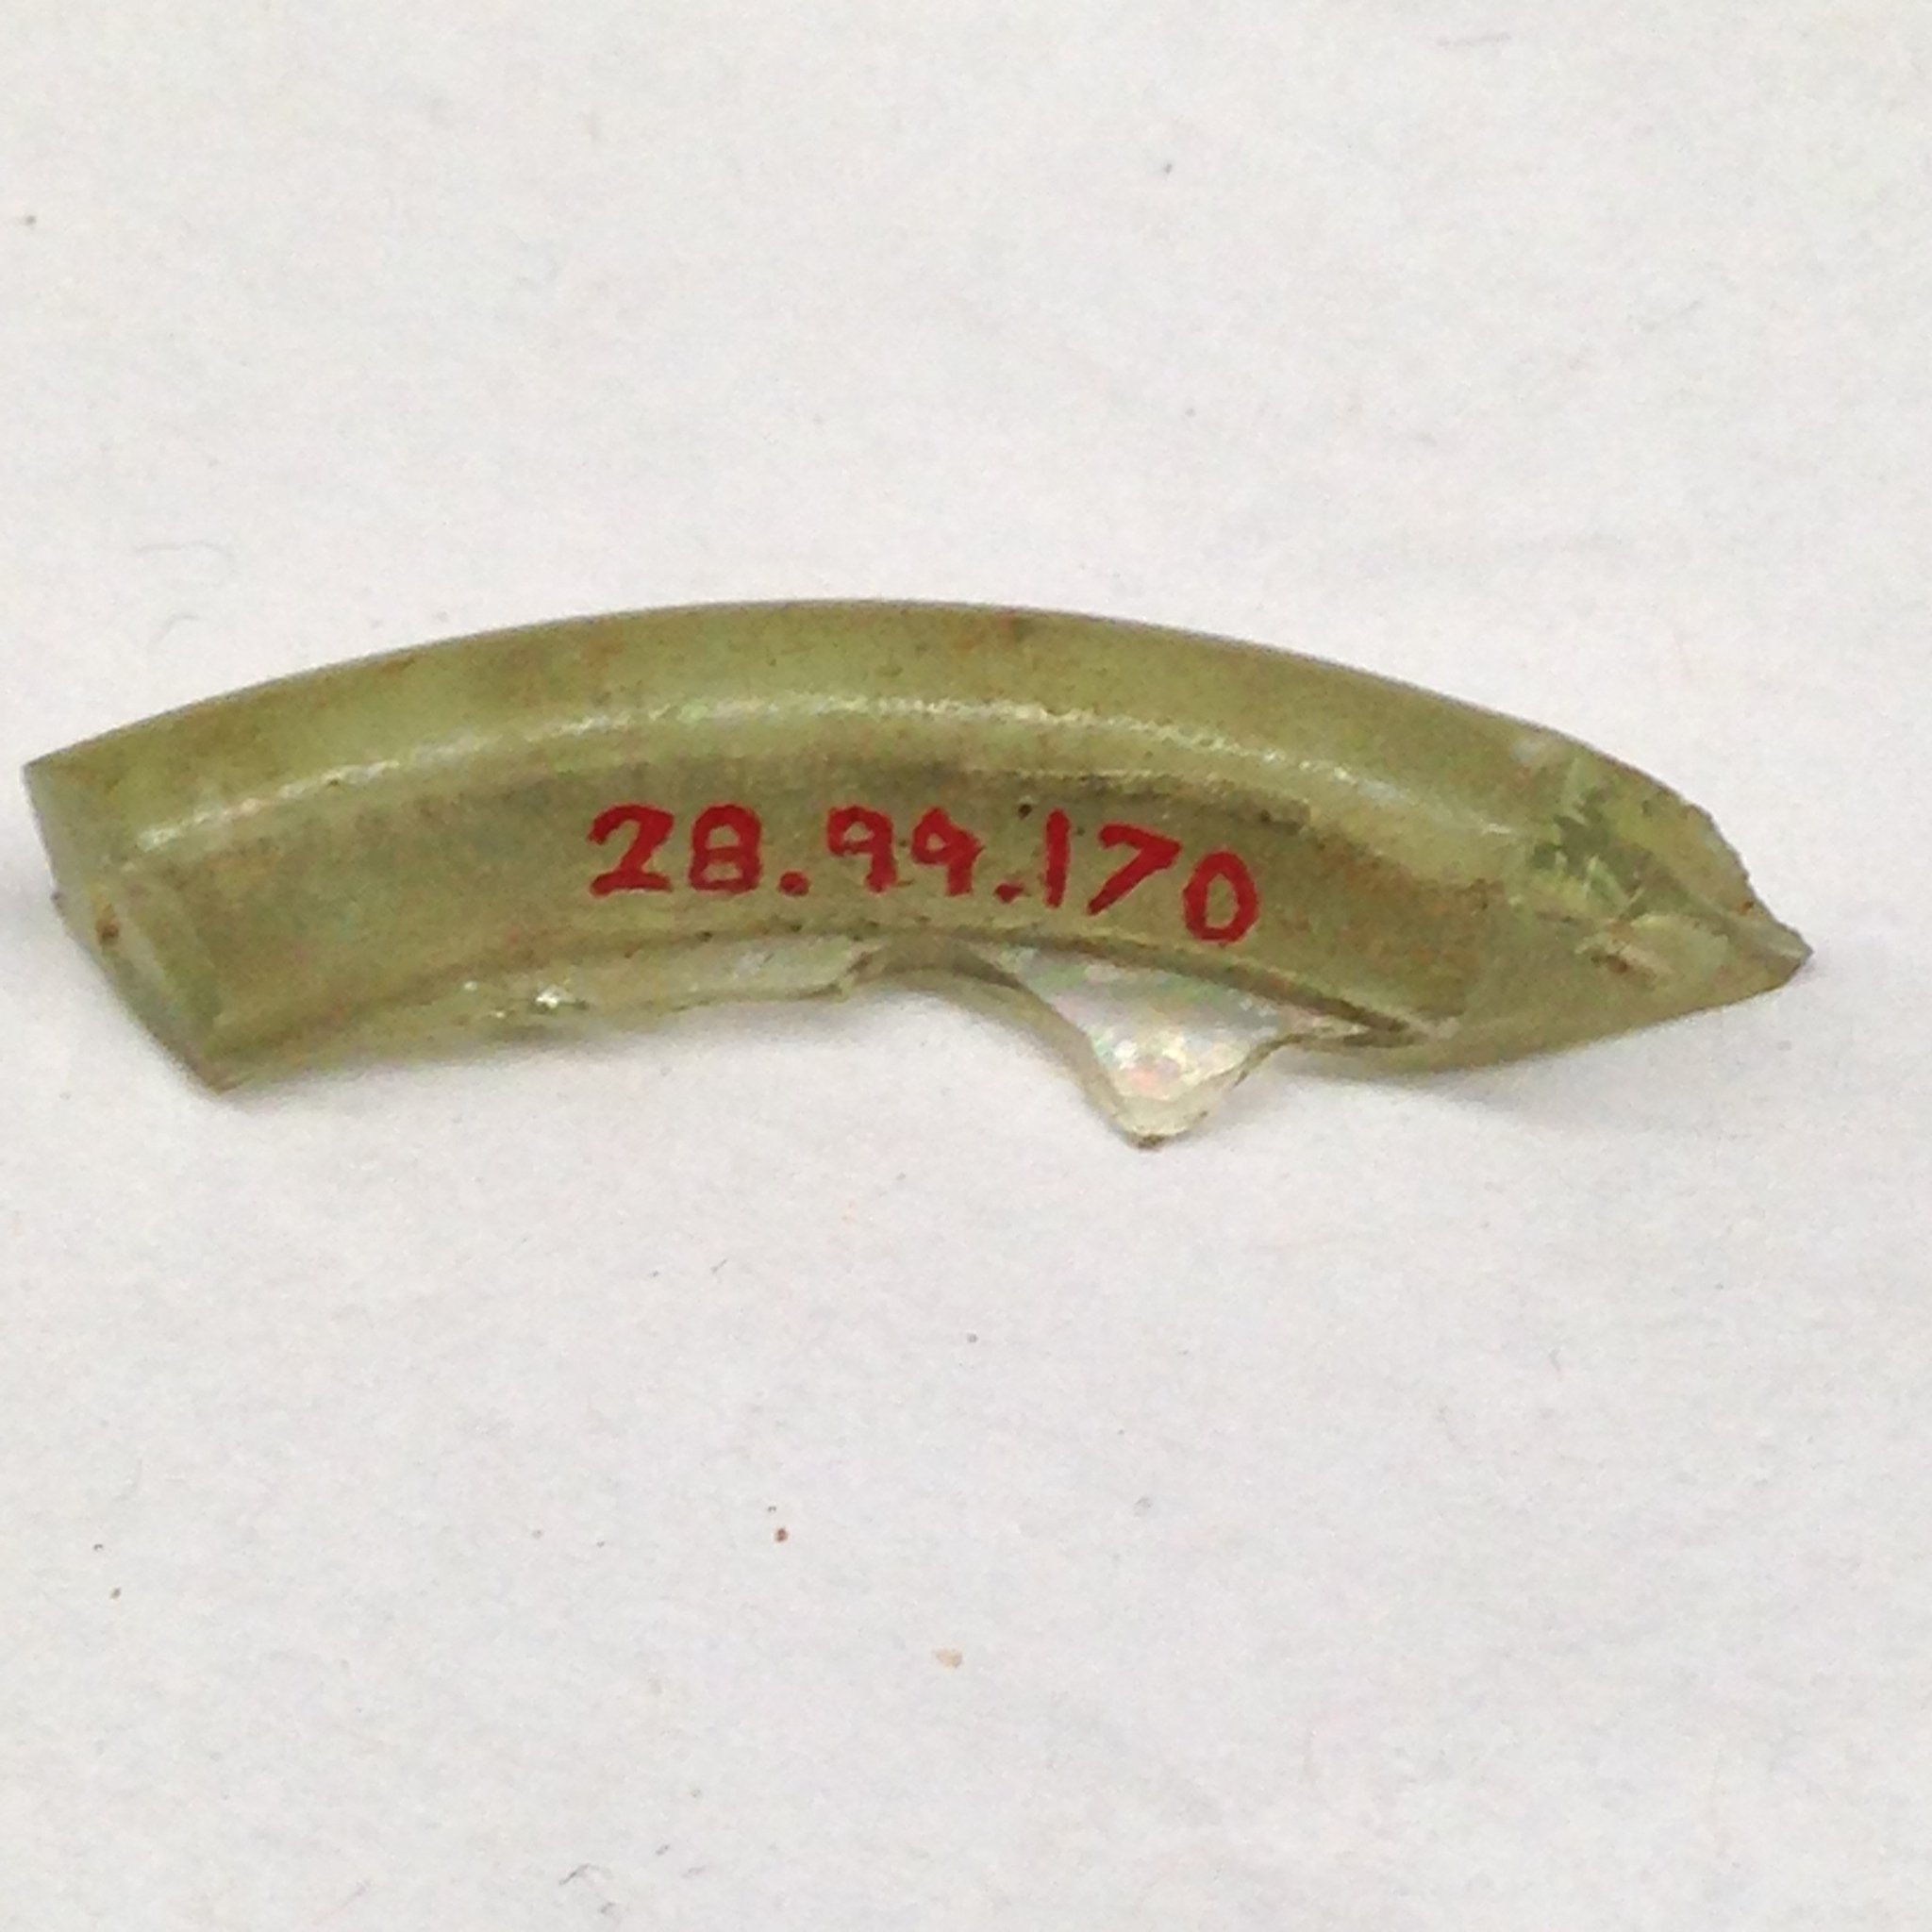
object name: fragment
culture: european or middle eastern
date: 1150-1250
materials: ceramic, glass